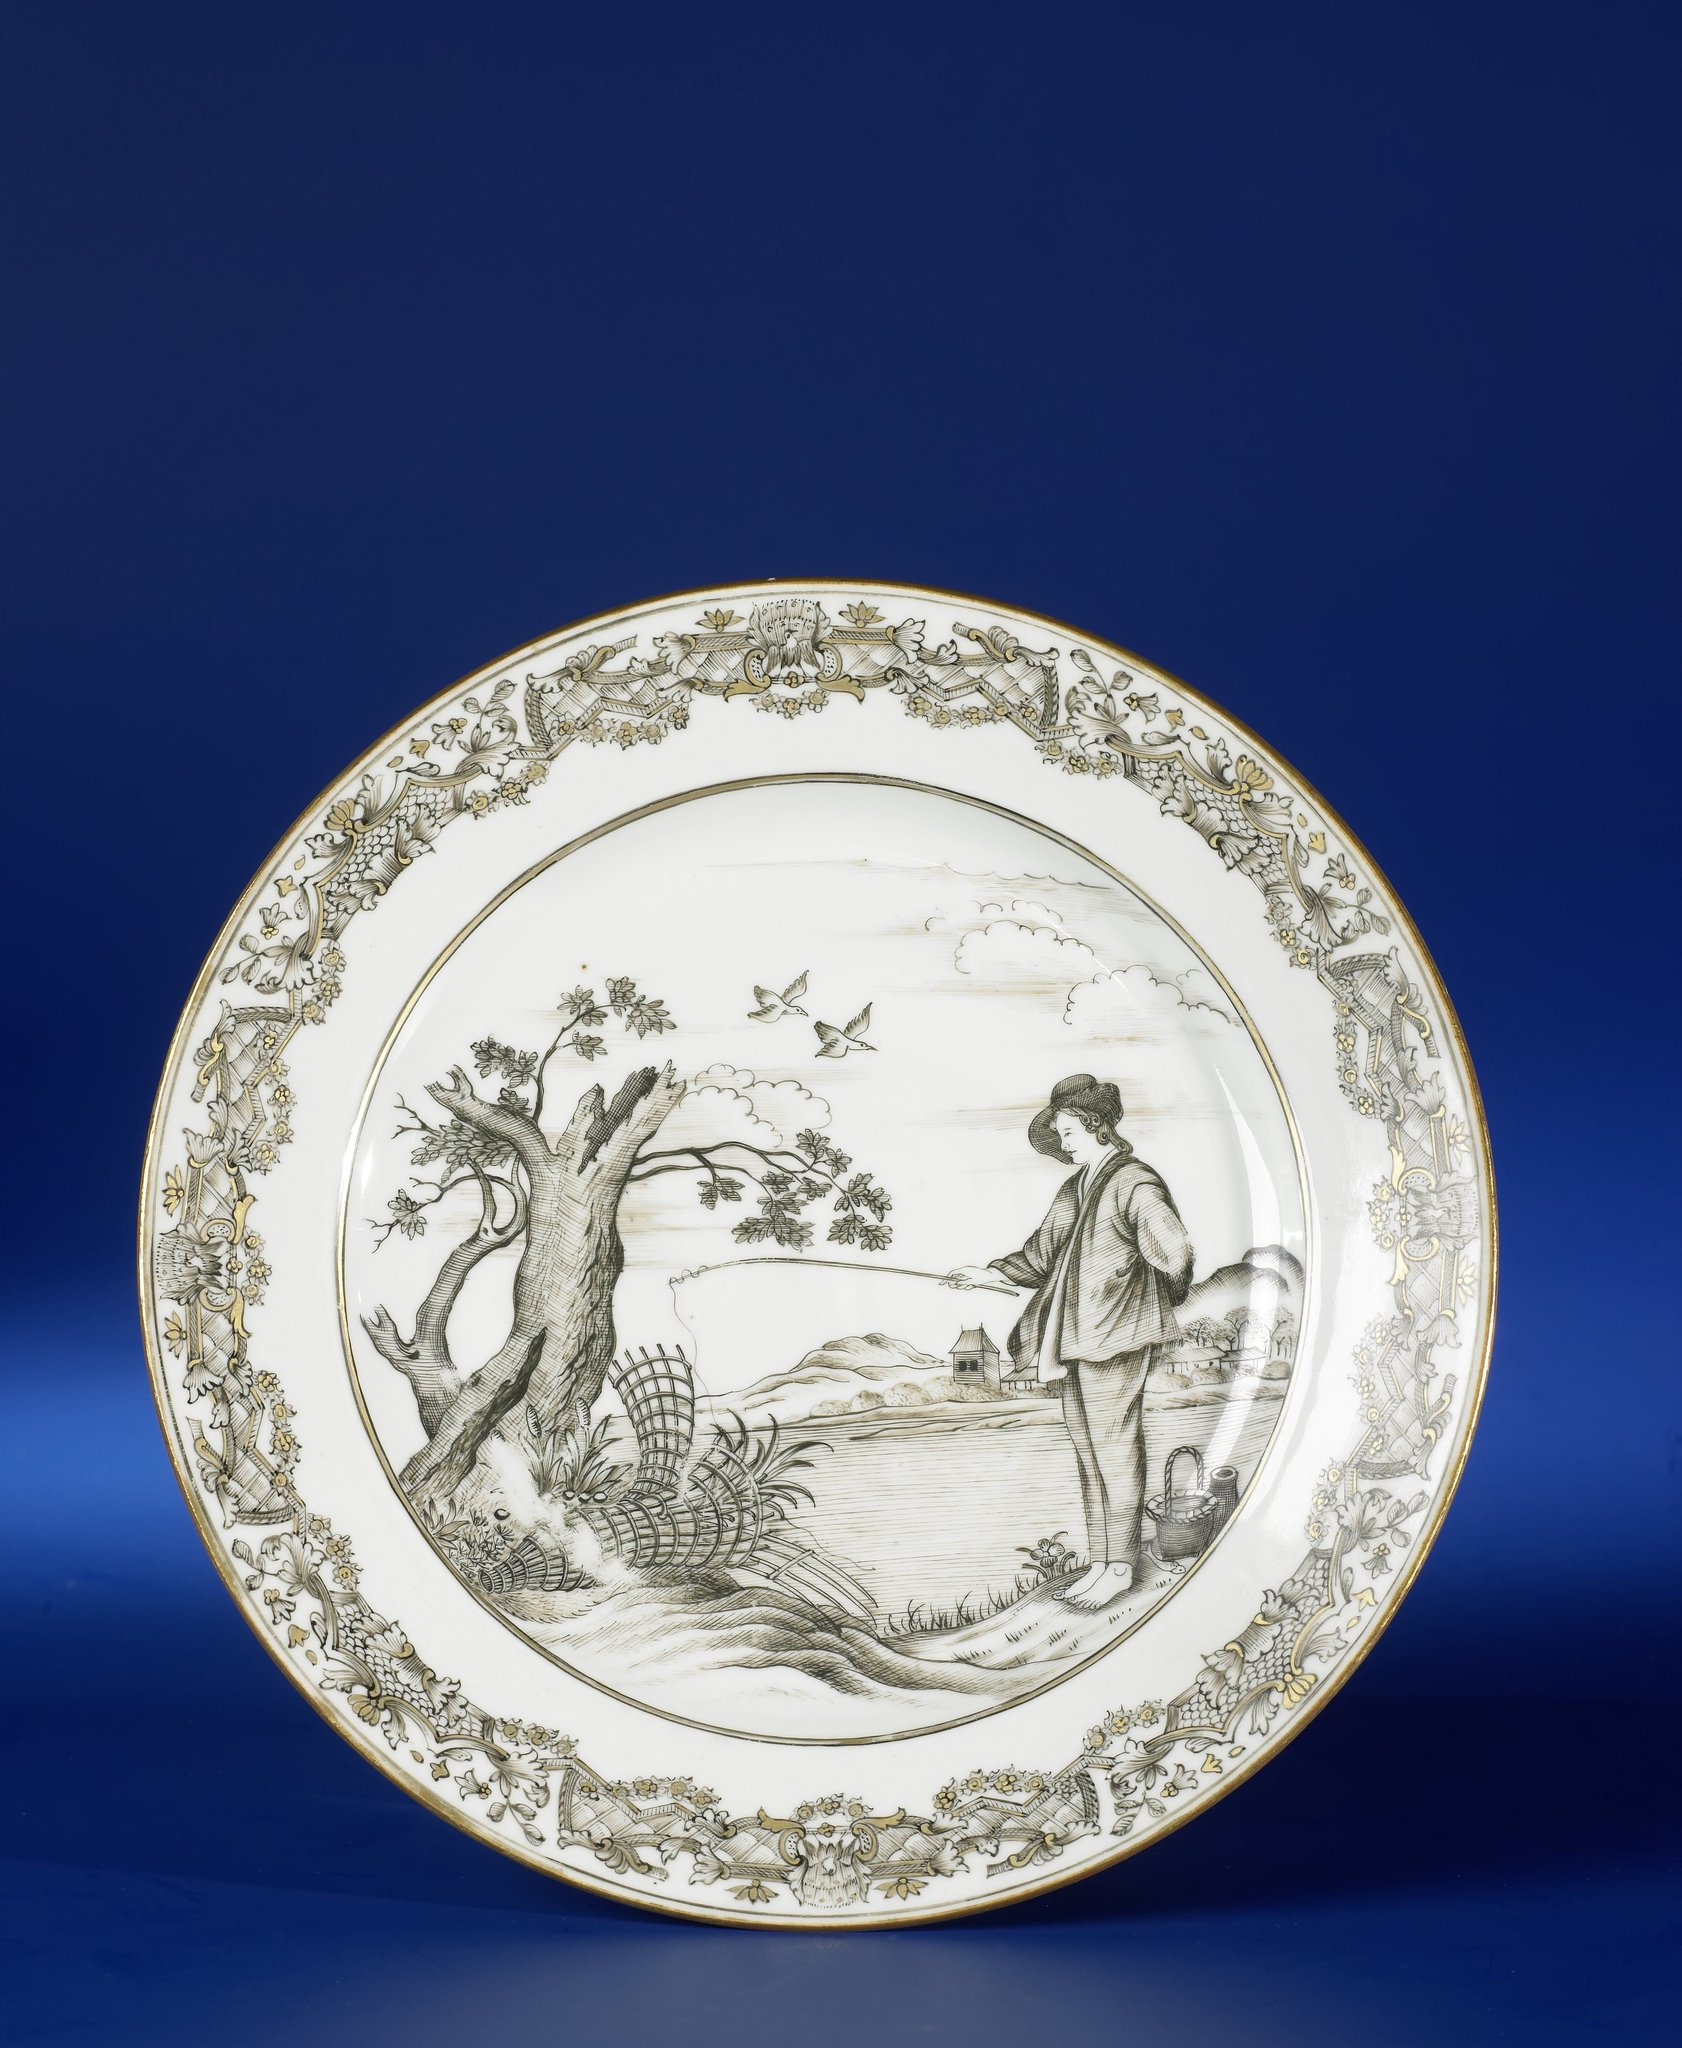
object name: plate dish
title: Plate with an image of The Young Fisherman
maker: Anonymous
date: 1740-1760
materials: glaze, gold, paint, porcelain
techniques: firing, gilding, turning, vitrification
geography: china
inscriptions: label: ‘16/ The Fisherman/ [...]’, label: ‘F. Bodenham/ Elmhurst, Hereford/ 52’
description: Bord op een voetring, gedecoreerd in encre de Chine en goud met een voorstelling van het Vissertje. De rand is versierd met een decoratief patroon. De voorstelling op het porselein werd geschilderd naar een prent van Abraham Bloemaert (1564-1651). Rechts is de hengelaar te zien, links een boom en op de voorgrond visnetten. Op de achtergrond een dorpje. Vissen, of hengelen, stond tijdens de 18de eeuw symbool voor het hengelen naar (de) liefde, en het net stond symbool voor waar deze liefde dan uiteindelijk in zou uitmonden, bijvoorbeeld het huwelijk.